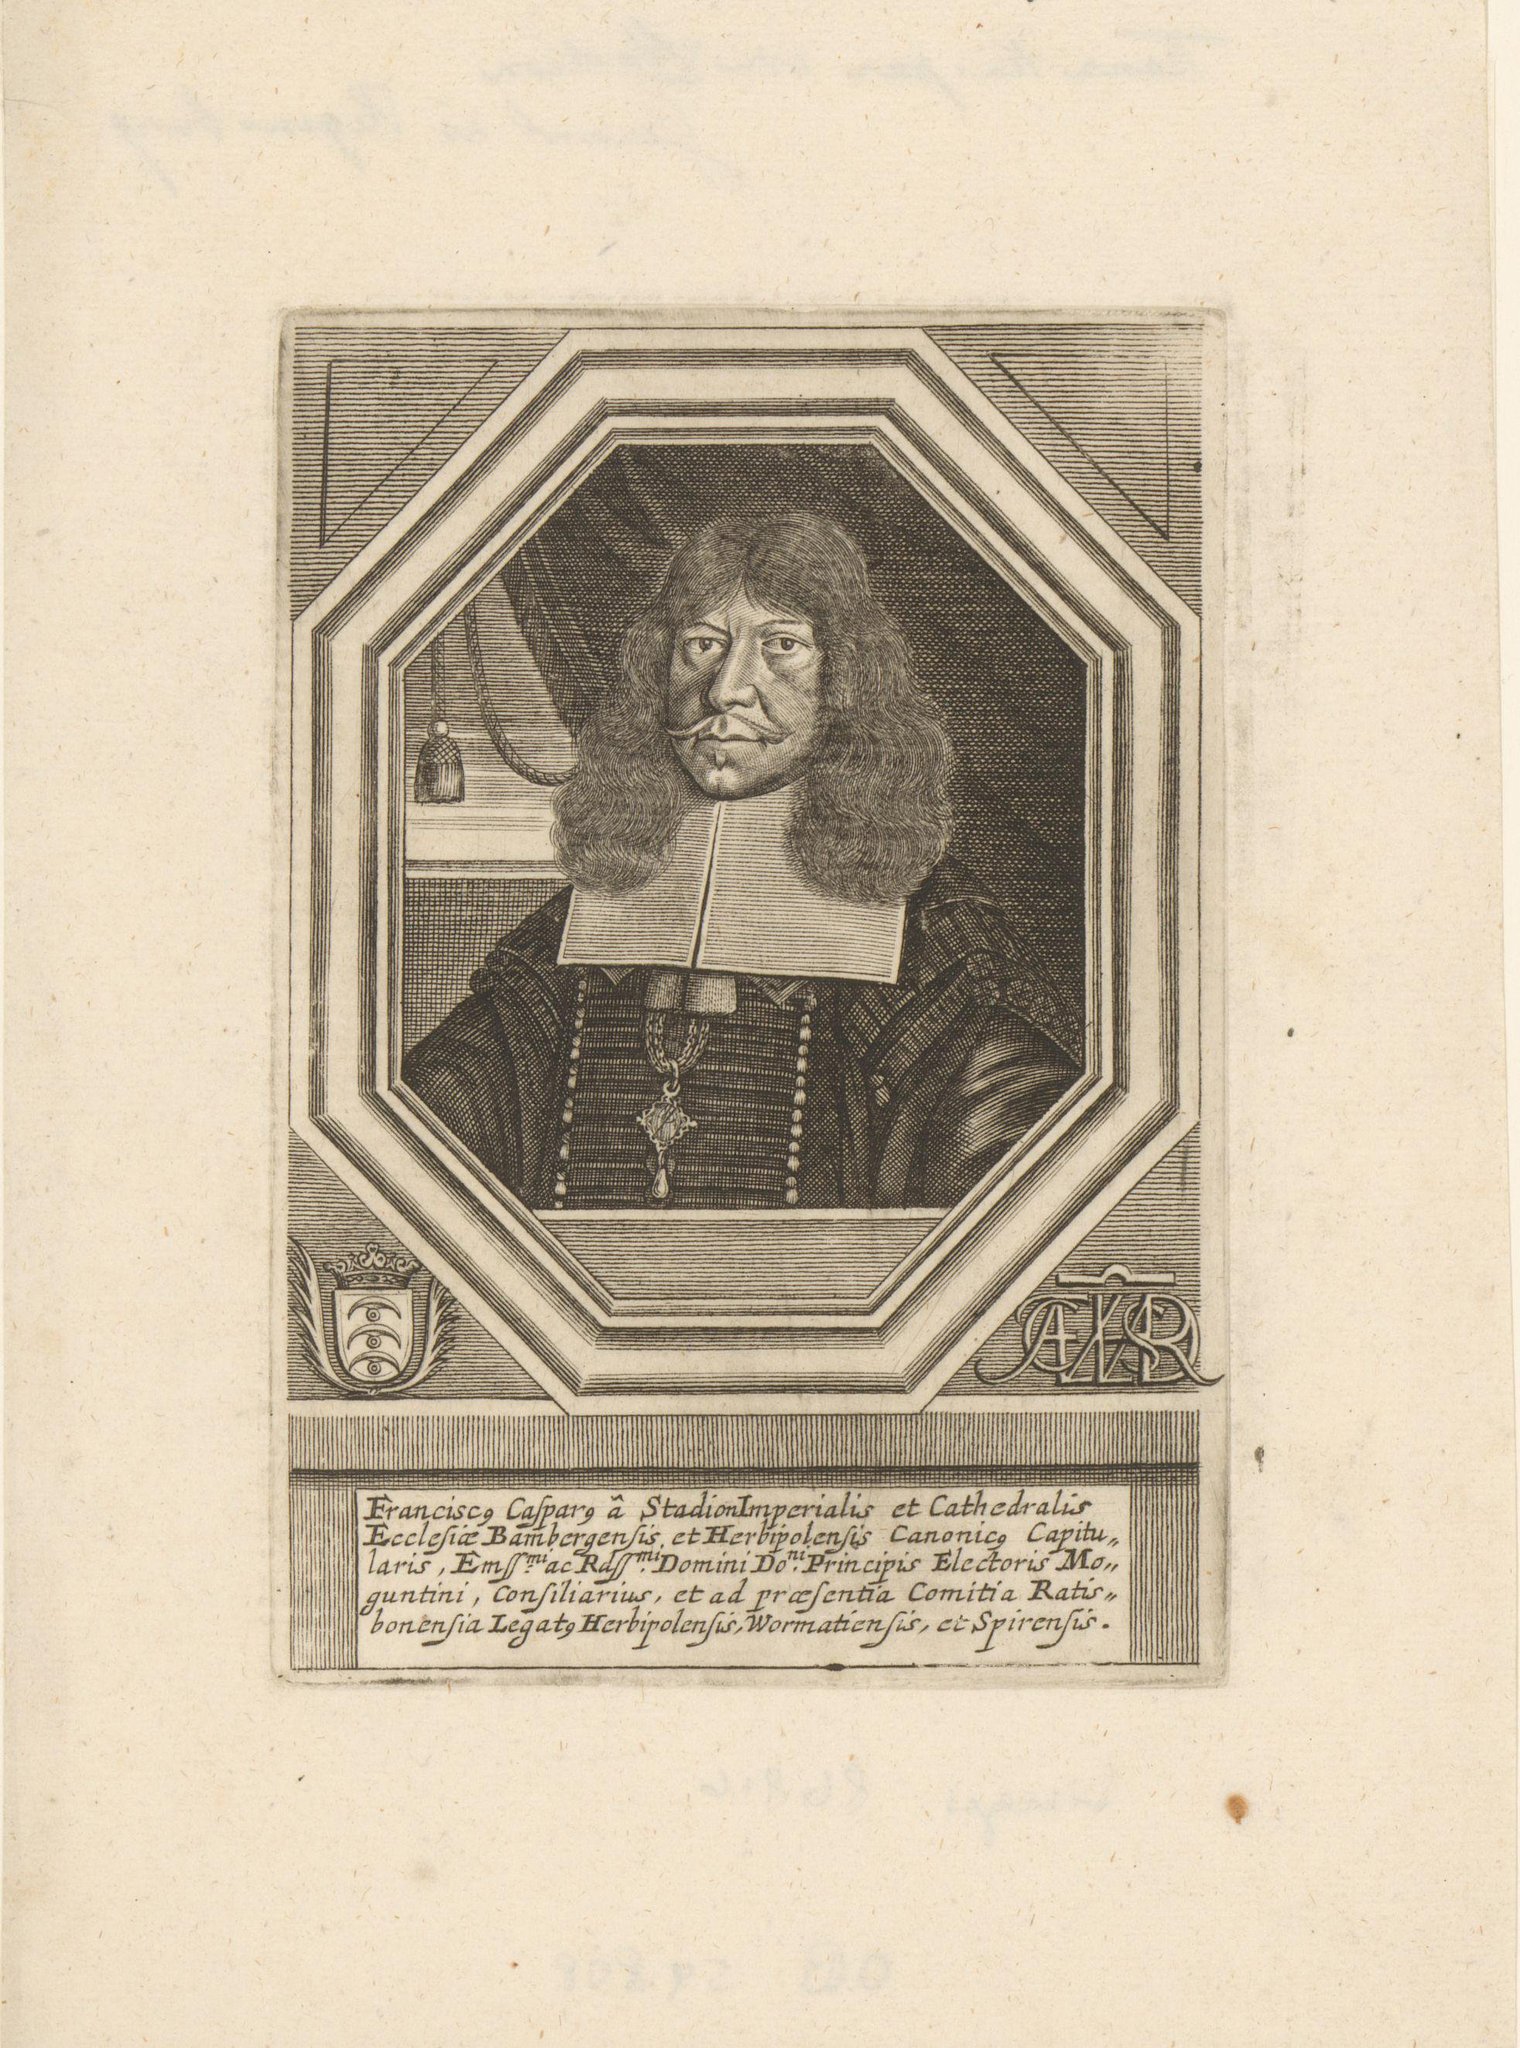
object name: print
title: Portret van Franz Kaspar von Stadion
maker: matthias van sommer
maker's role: draughtsman, print maker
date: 1667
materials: paper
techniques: engraving, etching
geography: germany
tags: historical persons, armorial bearing, heraldry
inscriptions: collector's mark: Lugt 2228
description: Volgens Hollstein werd de prent gebruikt voor de publicatie: Sommer, Matthias van. Hasce Omnium Electorum. Regensburg: s.n., 1667. Alhoewel op de titelpagina van de publicatie het jaar 1667 wordt vermeld, zijn meerdere prenten later gedateerd. Waarschijnlijk werd de publicatie pas in 1671 daadwerkelijk uitgegeven.